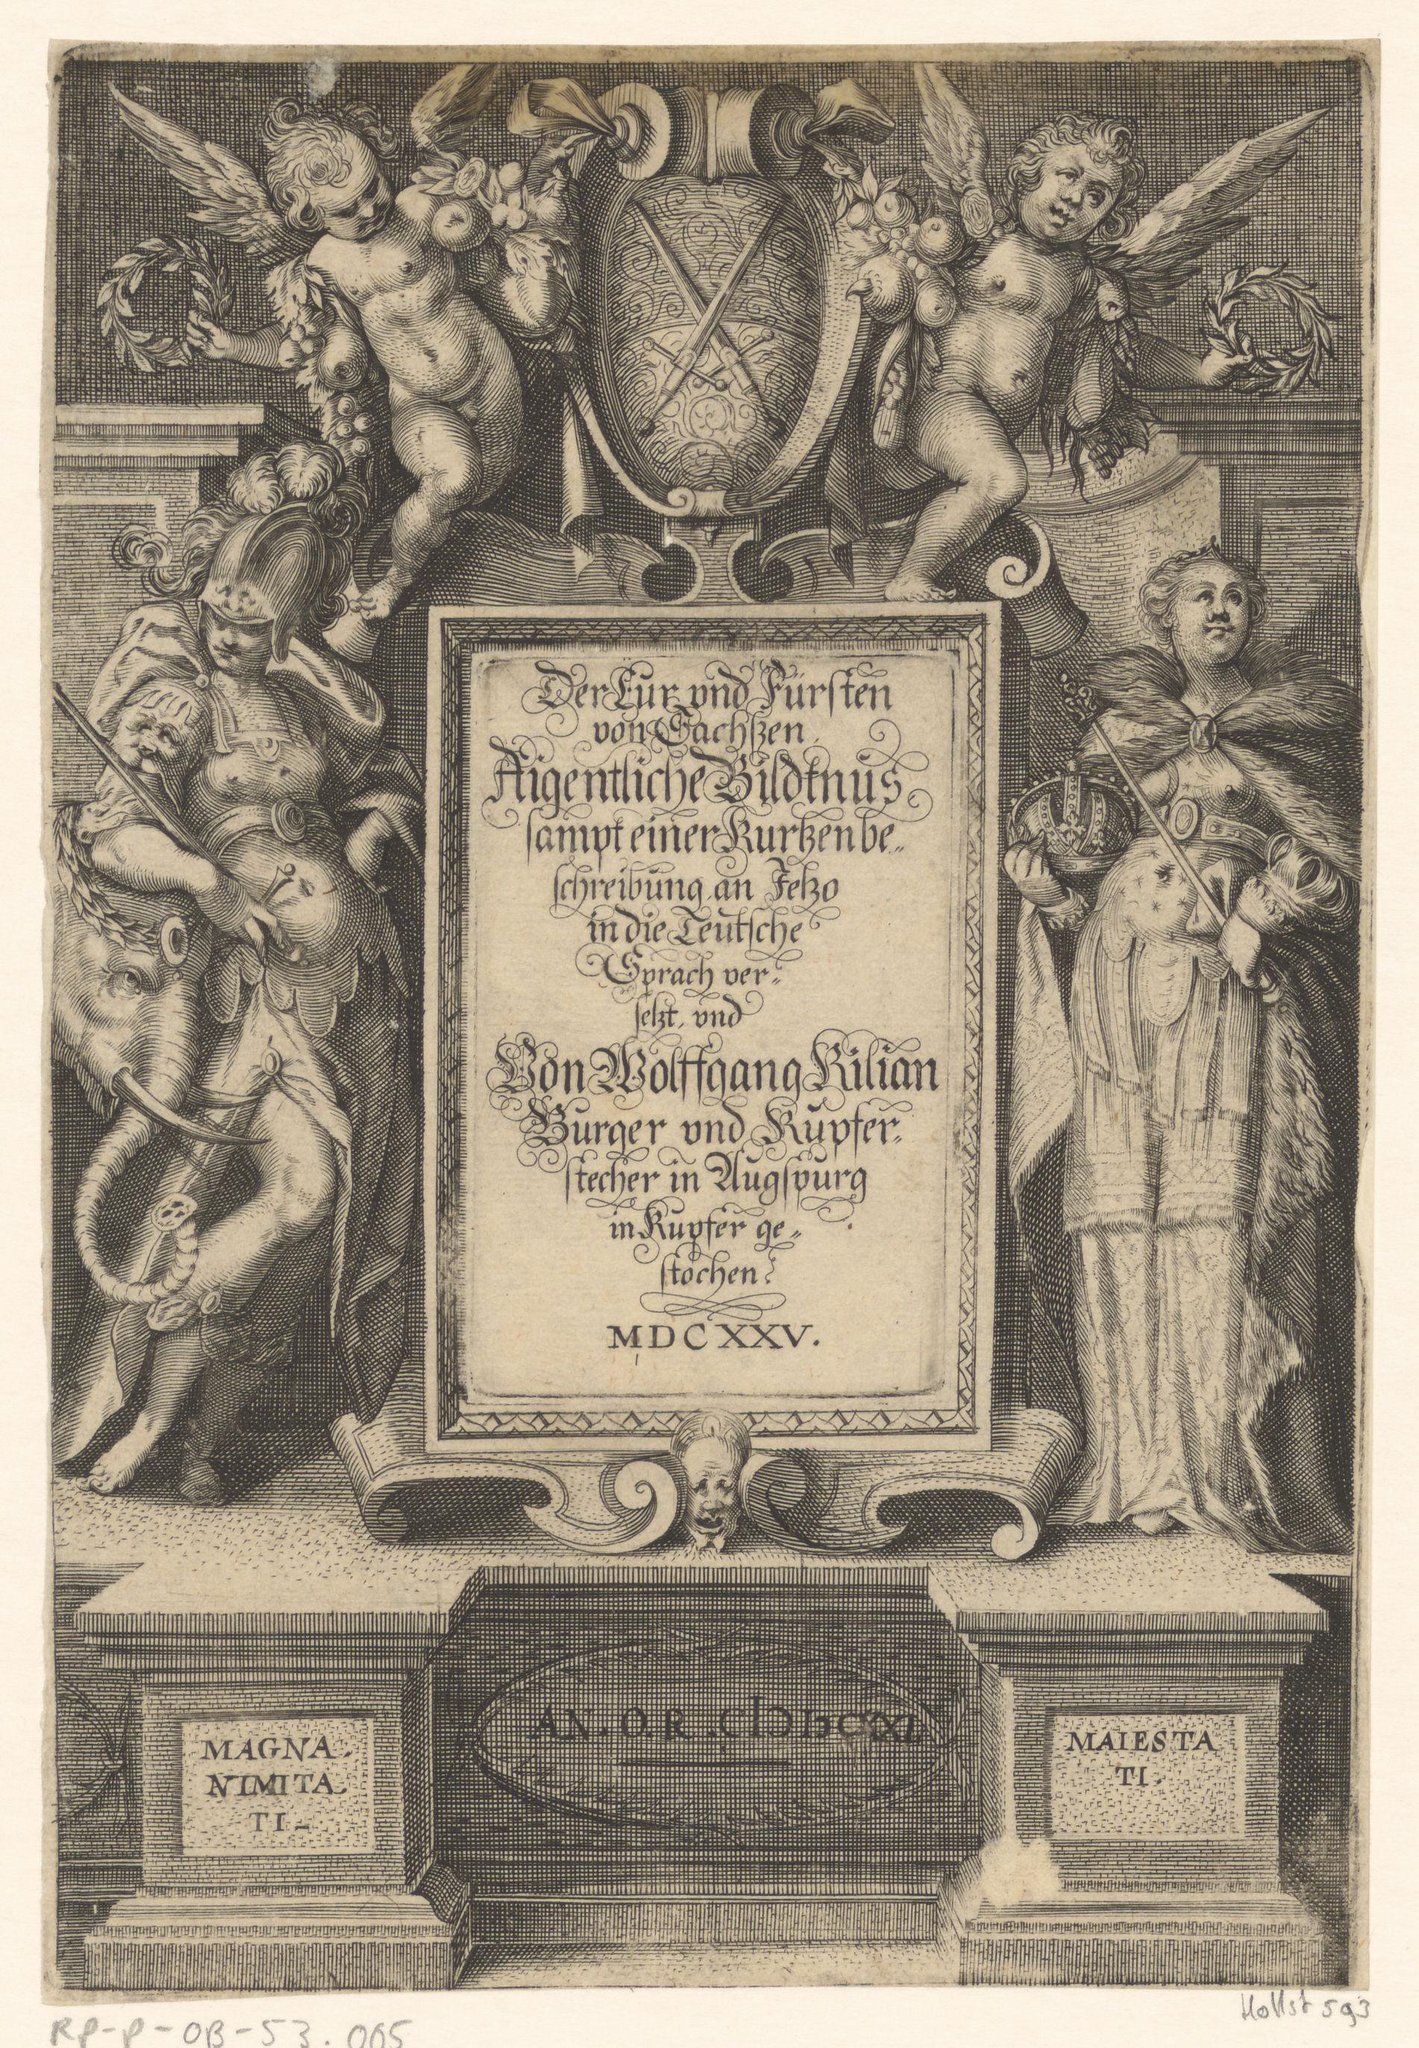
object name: print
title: Allegorie op heerschappij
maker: wolfgang kilian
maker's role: print maker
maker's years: 1581-1662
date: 1625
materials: paper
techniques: engraving, etching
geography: augsburg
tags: authority, power; 'dominio', 'giurisdittione' (ripa) (+ personification)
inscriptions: collector's mark: Lugt 2228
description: Deze prent is waarschijnlijk gebruikt in een Duitse versie van: Kilian, Wolfgang. Brevis et Succincta Descriptio omnium Saxoniae Electorum (...). S.l.s.n., 1625. De plaat van deze prent is, met afwijkende tekst in het centrale kader, voor het eerst gebruikt in: Henning, Marcus. Saxoniae Ducum, Caesarib. Creando VII virum, et caeterorum (...). Augsburg: Dominicus Custos, 1601.